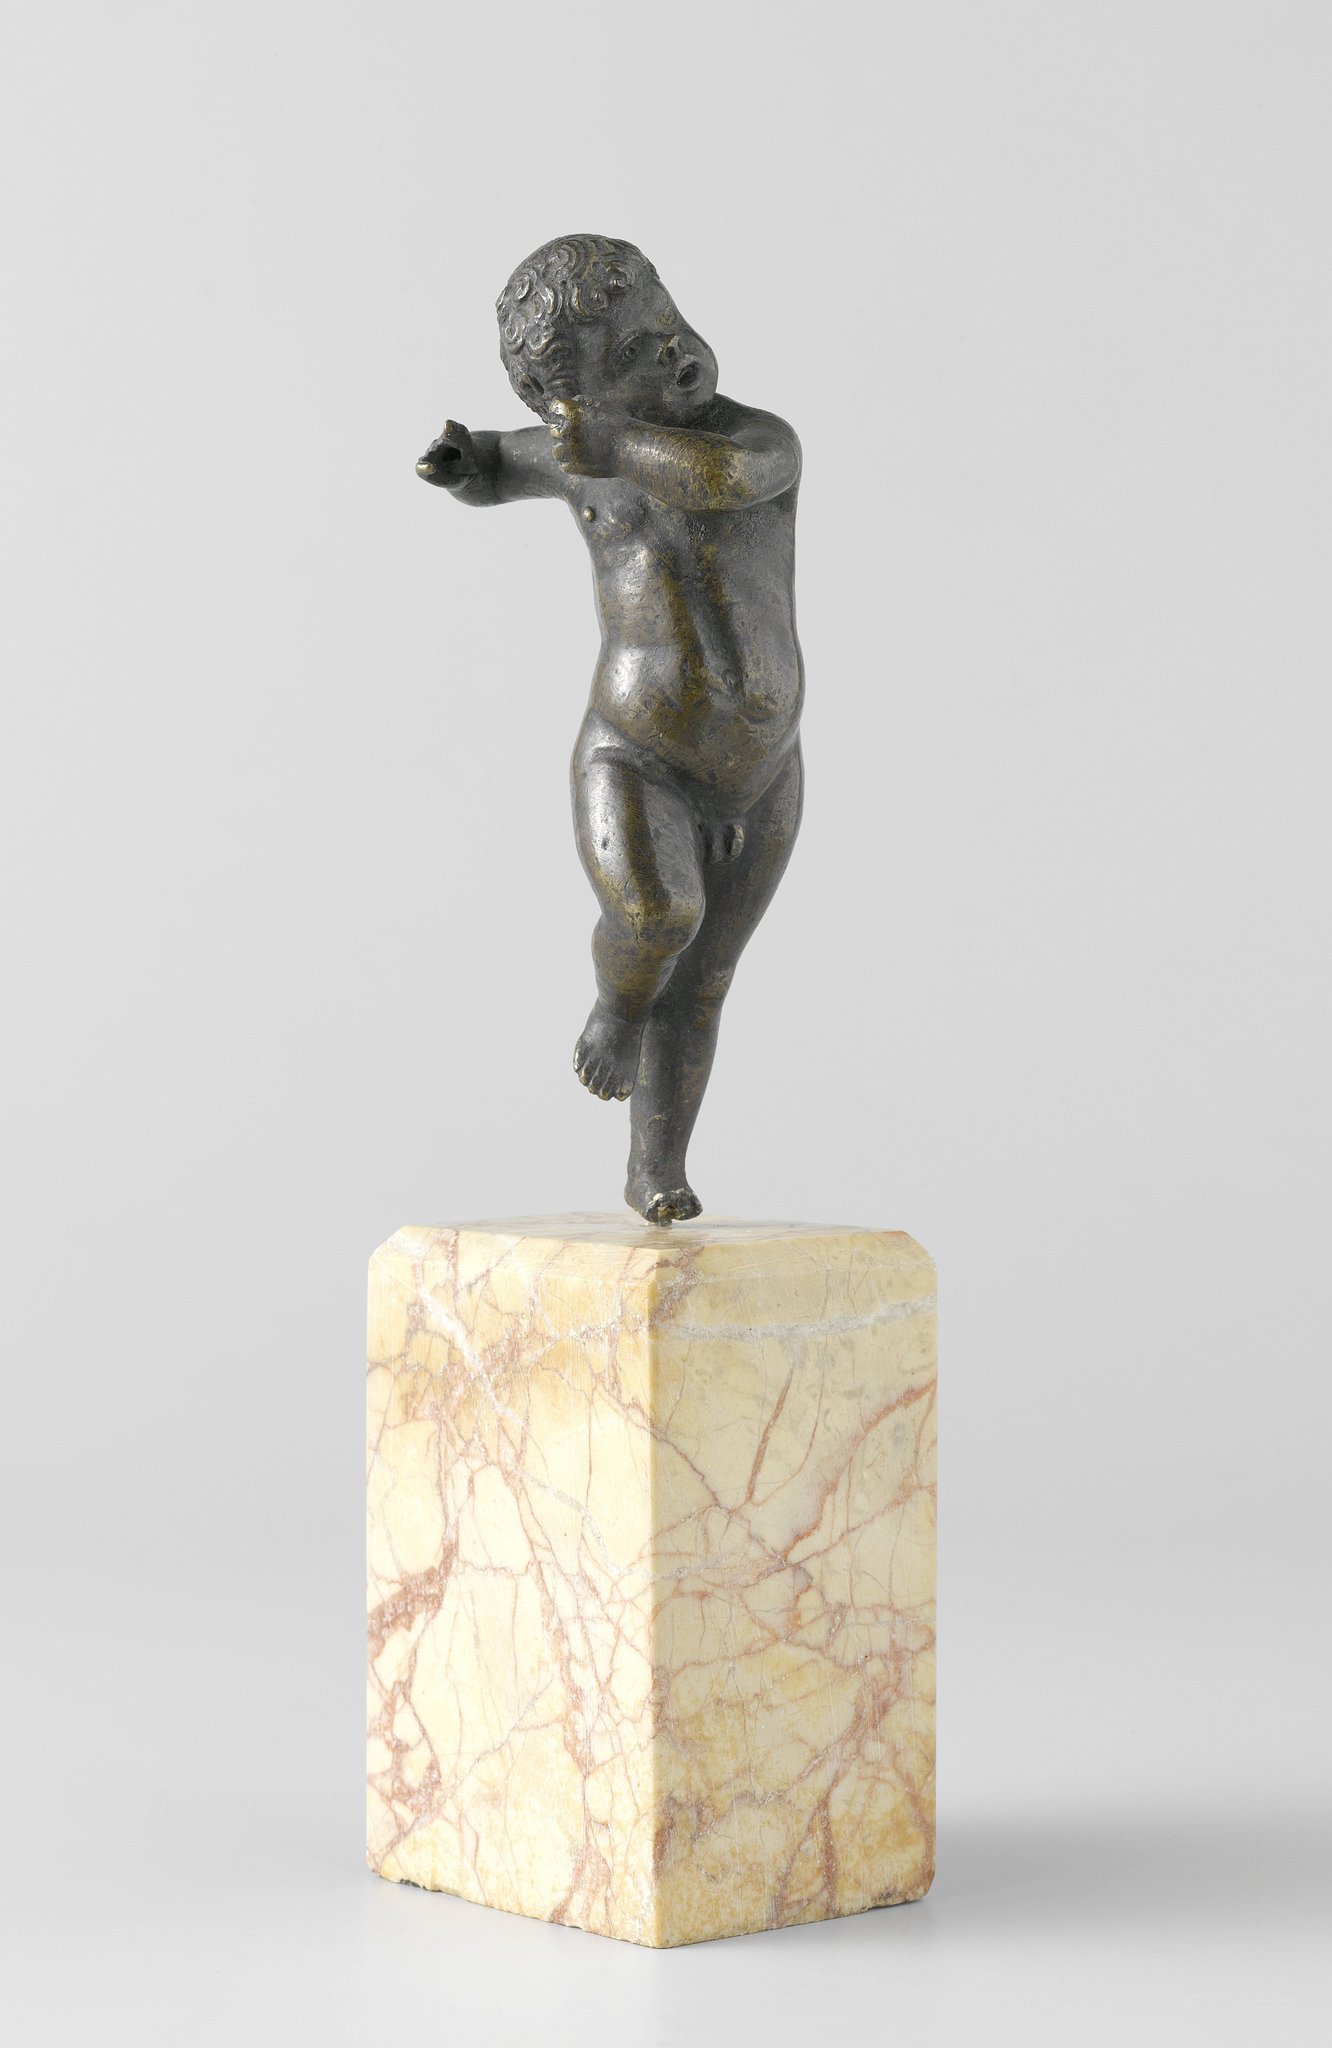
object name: sculpture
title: Dansende Amor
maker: andrea briosco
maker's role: designer, sculptor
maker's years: 1470-1532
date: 1500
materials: bronze